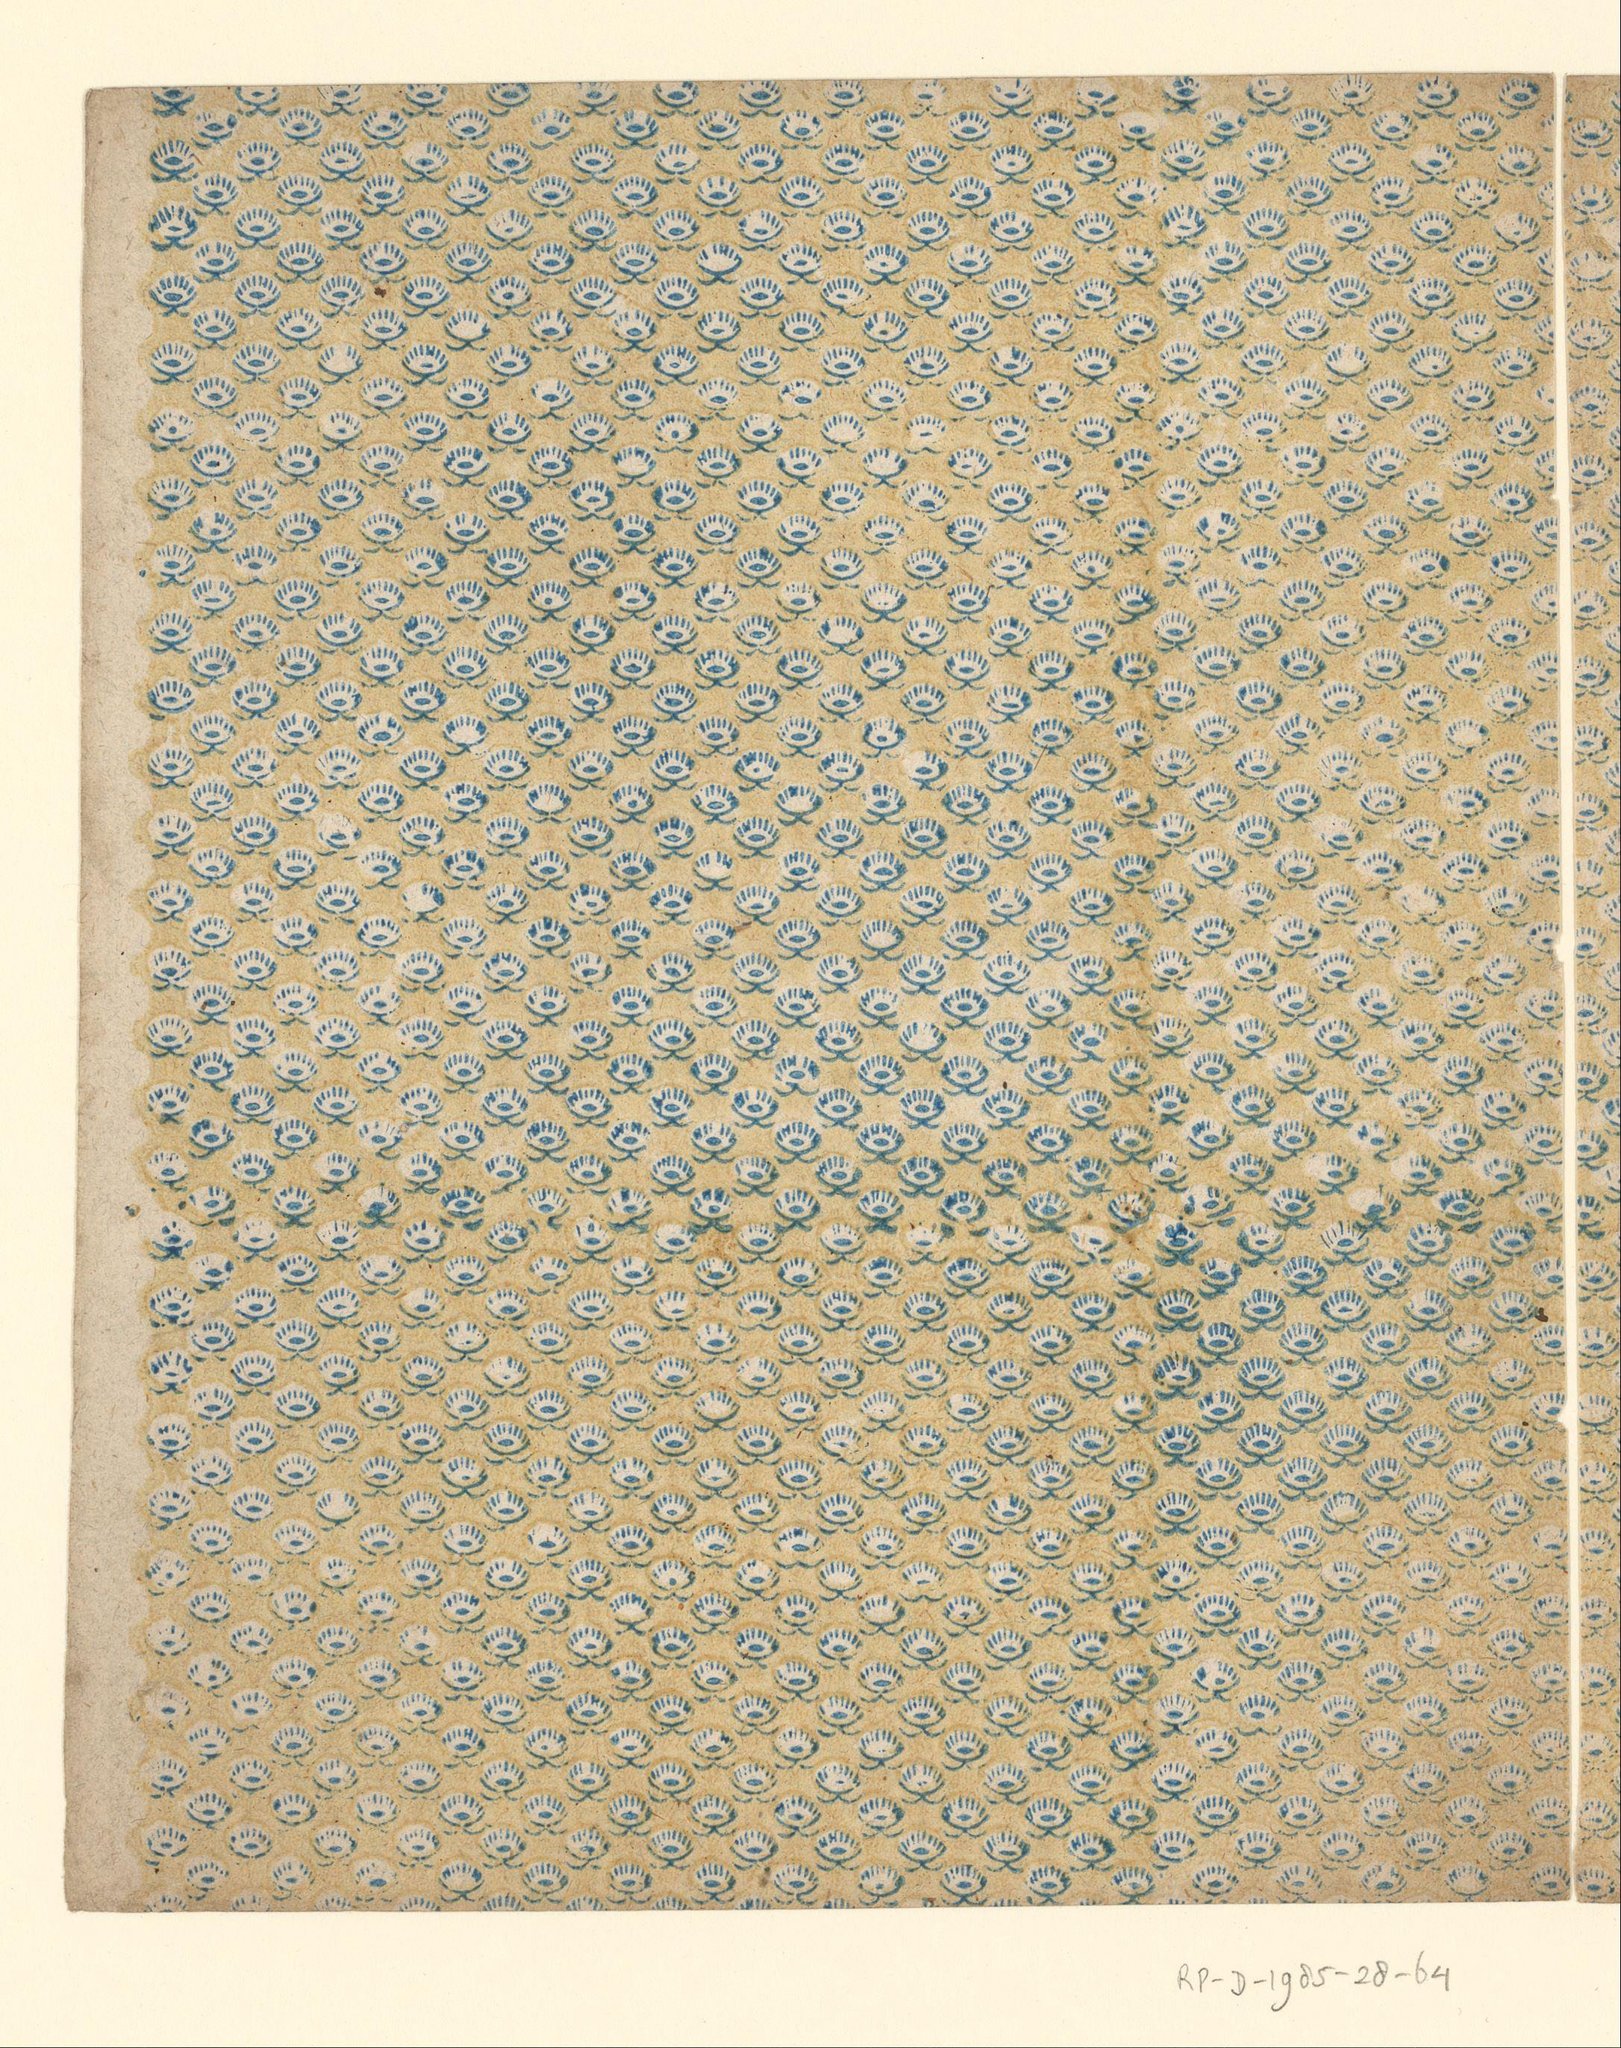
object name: wrapper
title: Blad met strooipatroon van een bloemmotief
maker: Anonymous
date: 1750-1900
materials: paper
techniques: printing block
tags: ornament derived from plant forms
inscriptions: collector's mark: Lugt 2760, collector's mark: Lugt 2228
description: Blad met strooipatroon van een bloemmotief. Helft van een omslag.